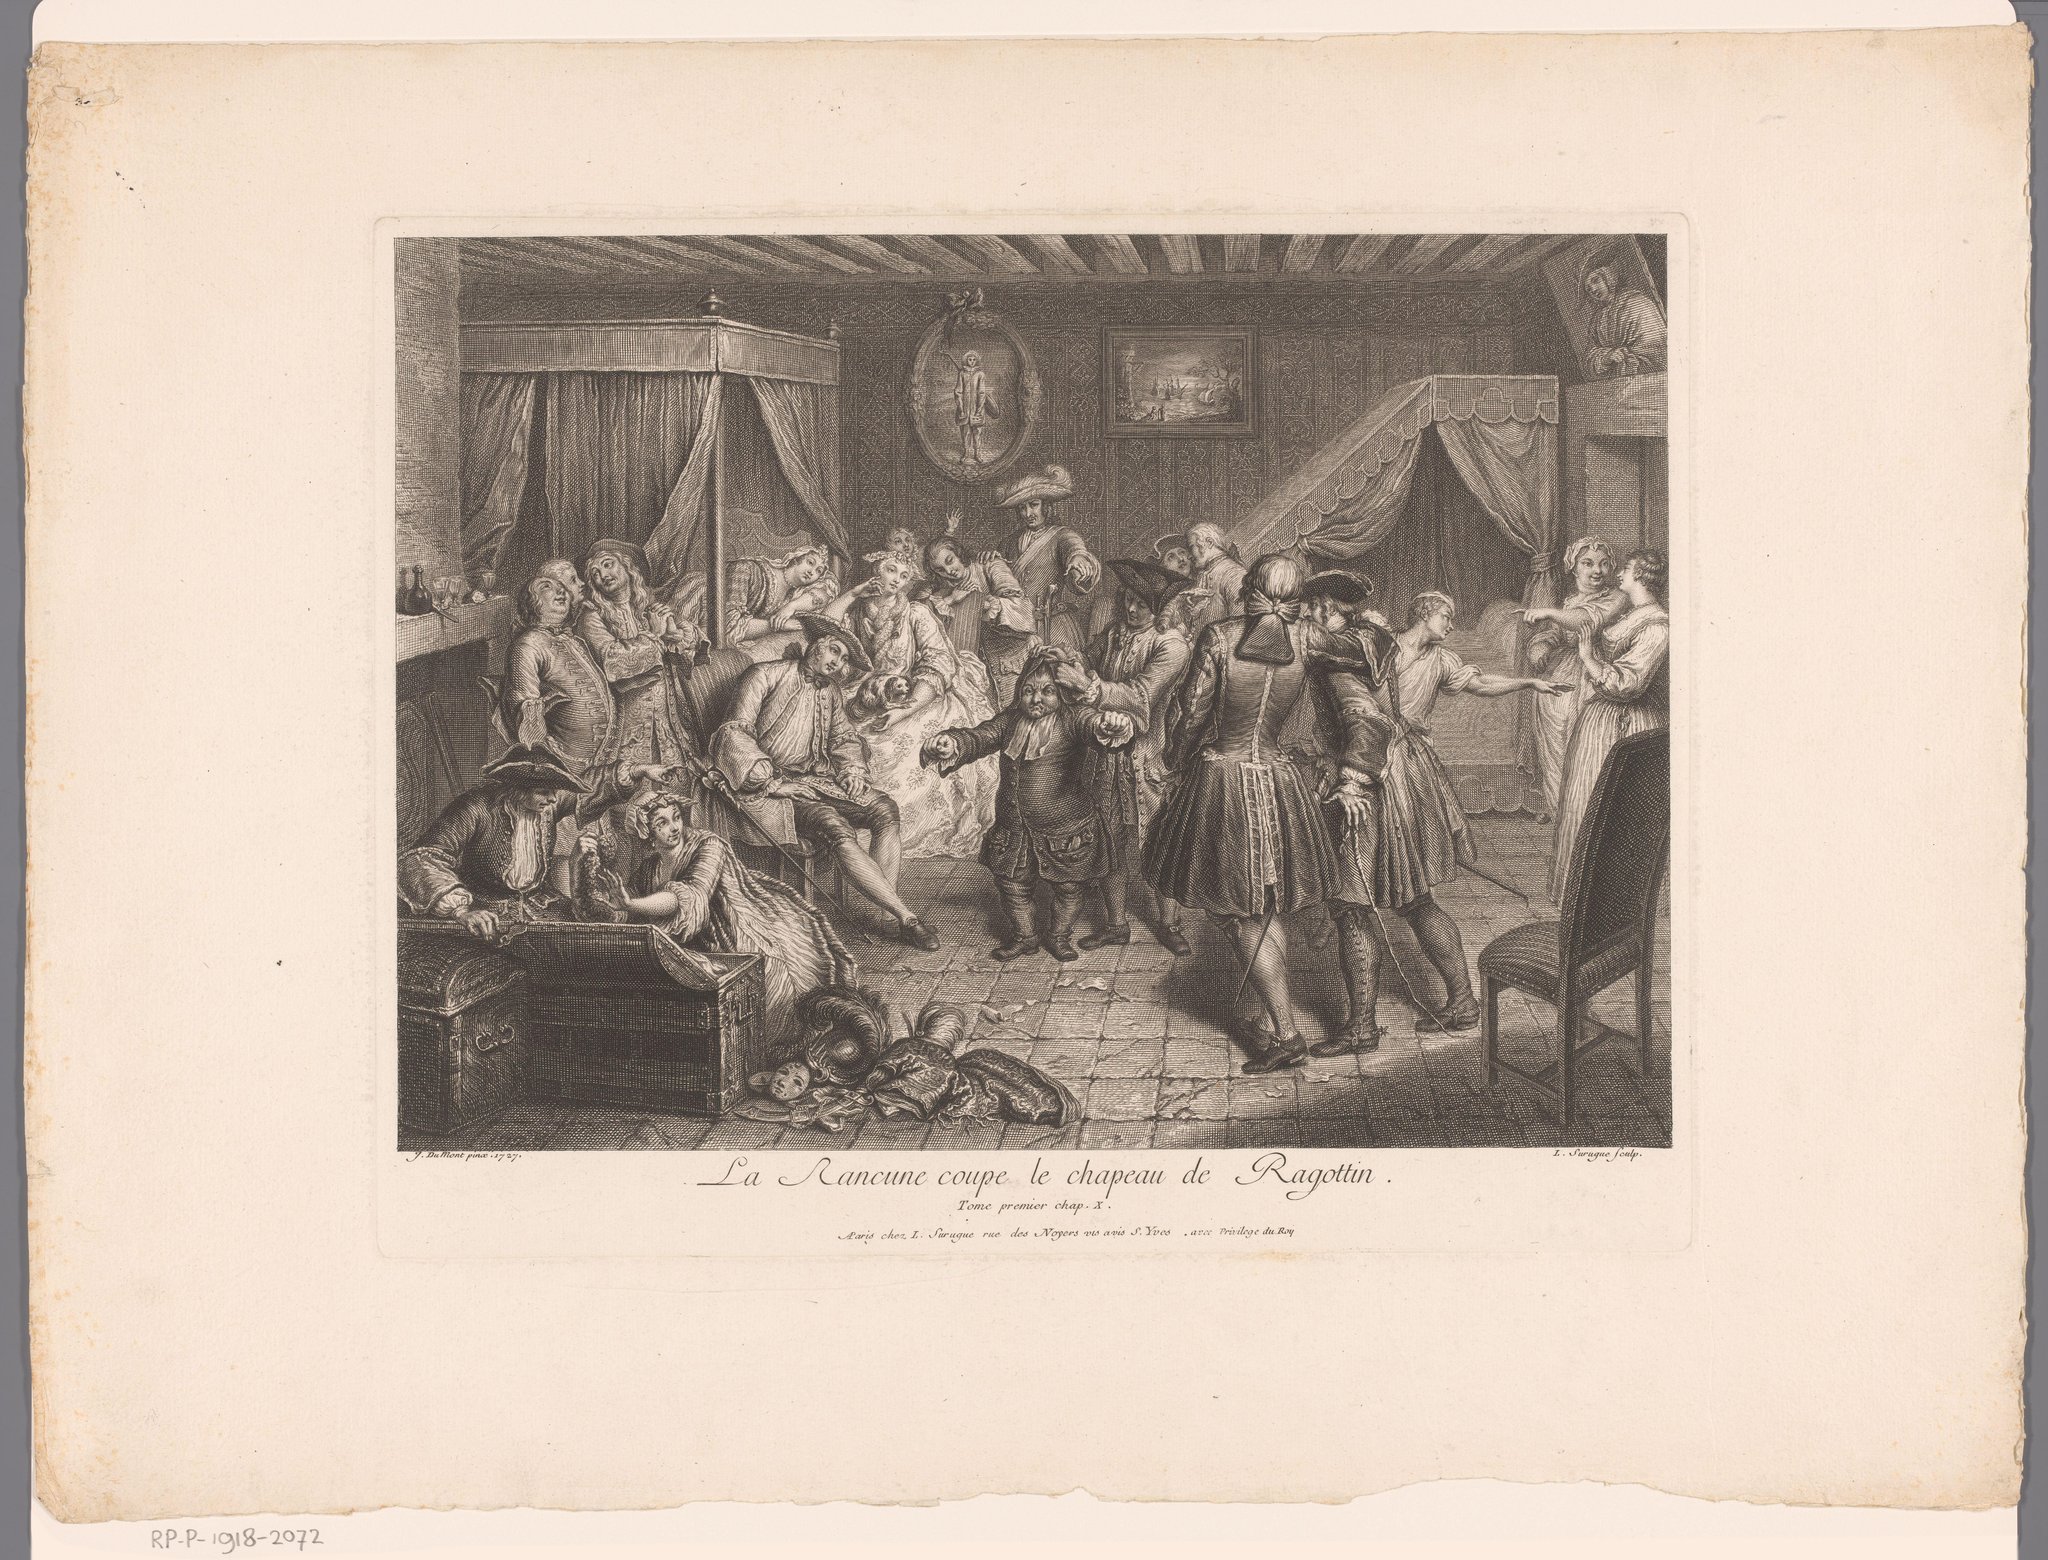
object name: print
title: La Rancune coupe le chapeau de Ragottin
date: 1729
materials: paper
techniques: engraving, etching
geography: paris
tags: (scarron, roman comique) specific works of literature (with author, title)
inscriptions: collector's mark: Lugt 2233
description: Serie van 16 prenten bij de Roman Comique van Scarron, waarvan een aantal door Louis en Pierre Louis Surugue.